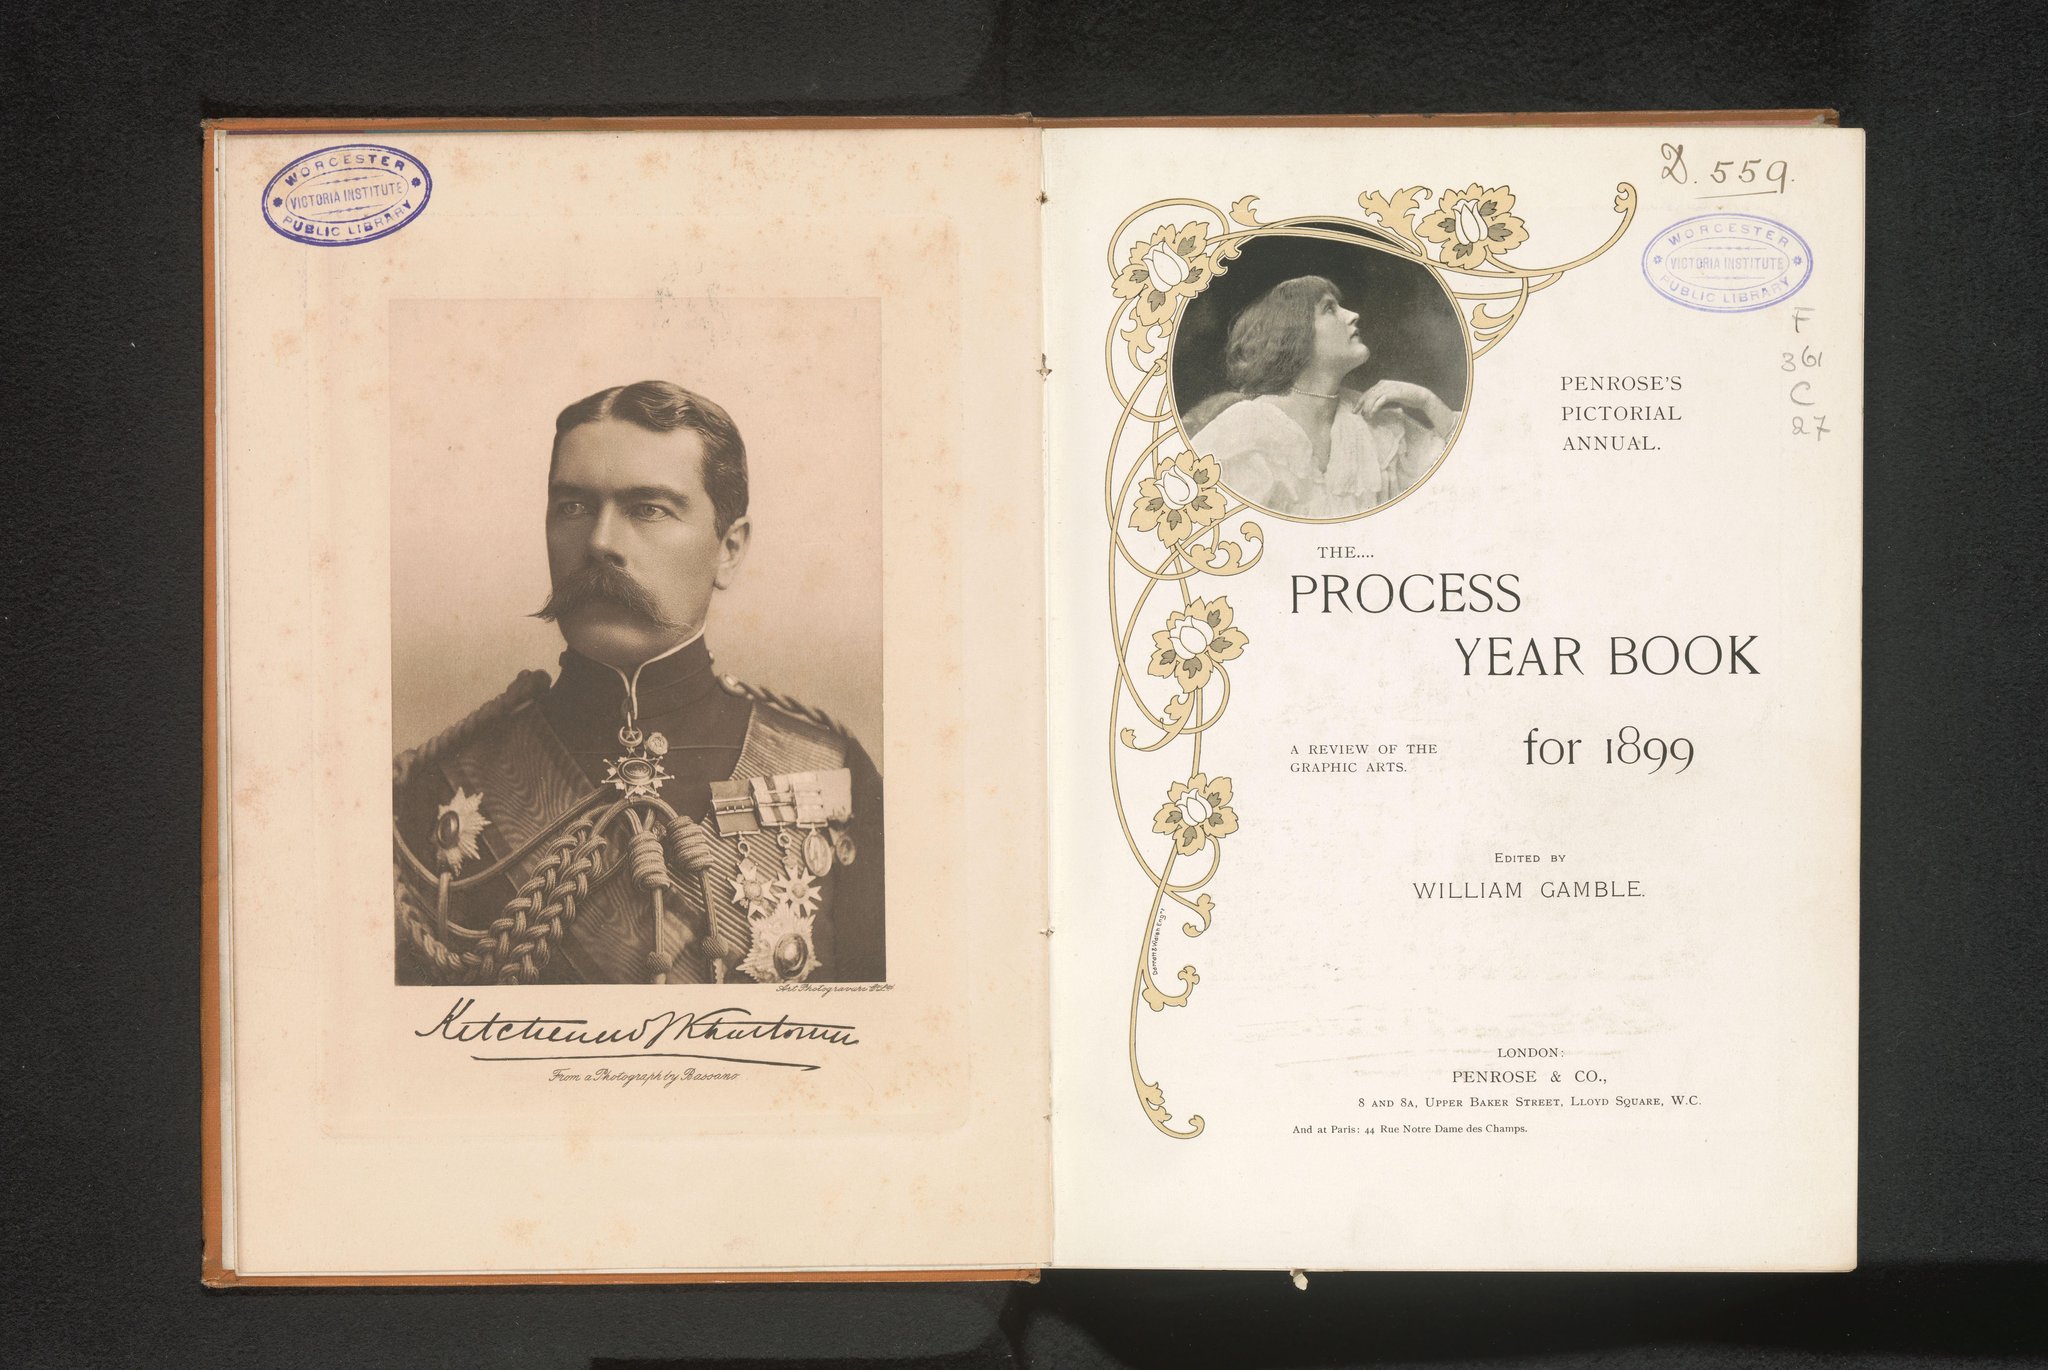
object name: book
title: The process year book for 1899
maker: william gamble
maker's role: auteur, redacteur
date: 1899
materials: linen, paper, photographic process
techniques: photograph, photoaquatint, printing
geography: london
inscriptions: collector's mark: ‘Worcester Public Library/ Victoria Institute’, date: ‘NOV 1995’, date: ‘20 SEP. 1916/ 14 APR 28’, annotation: ‘D 559’